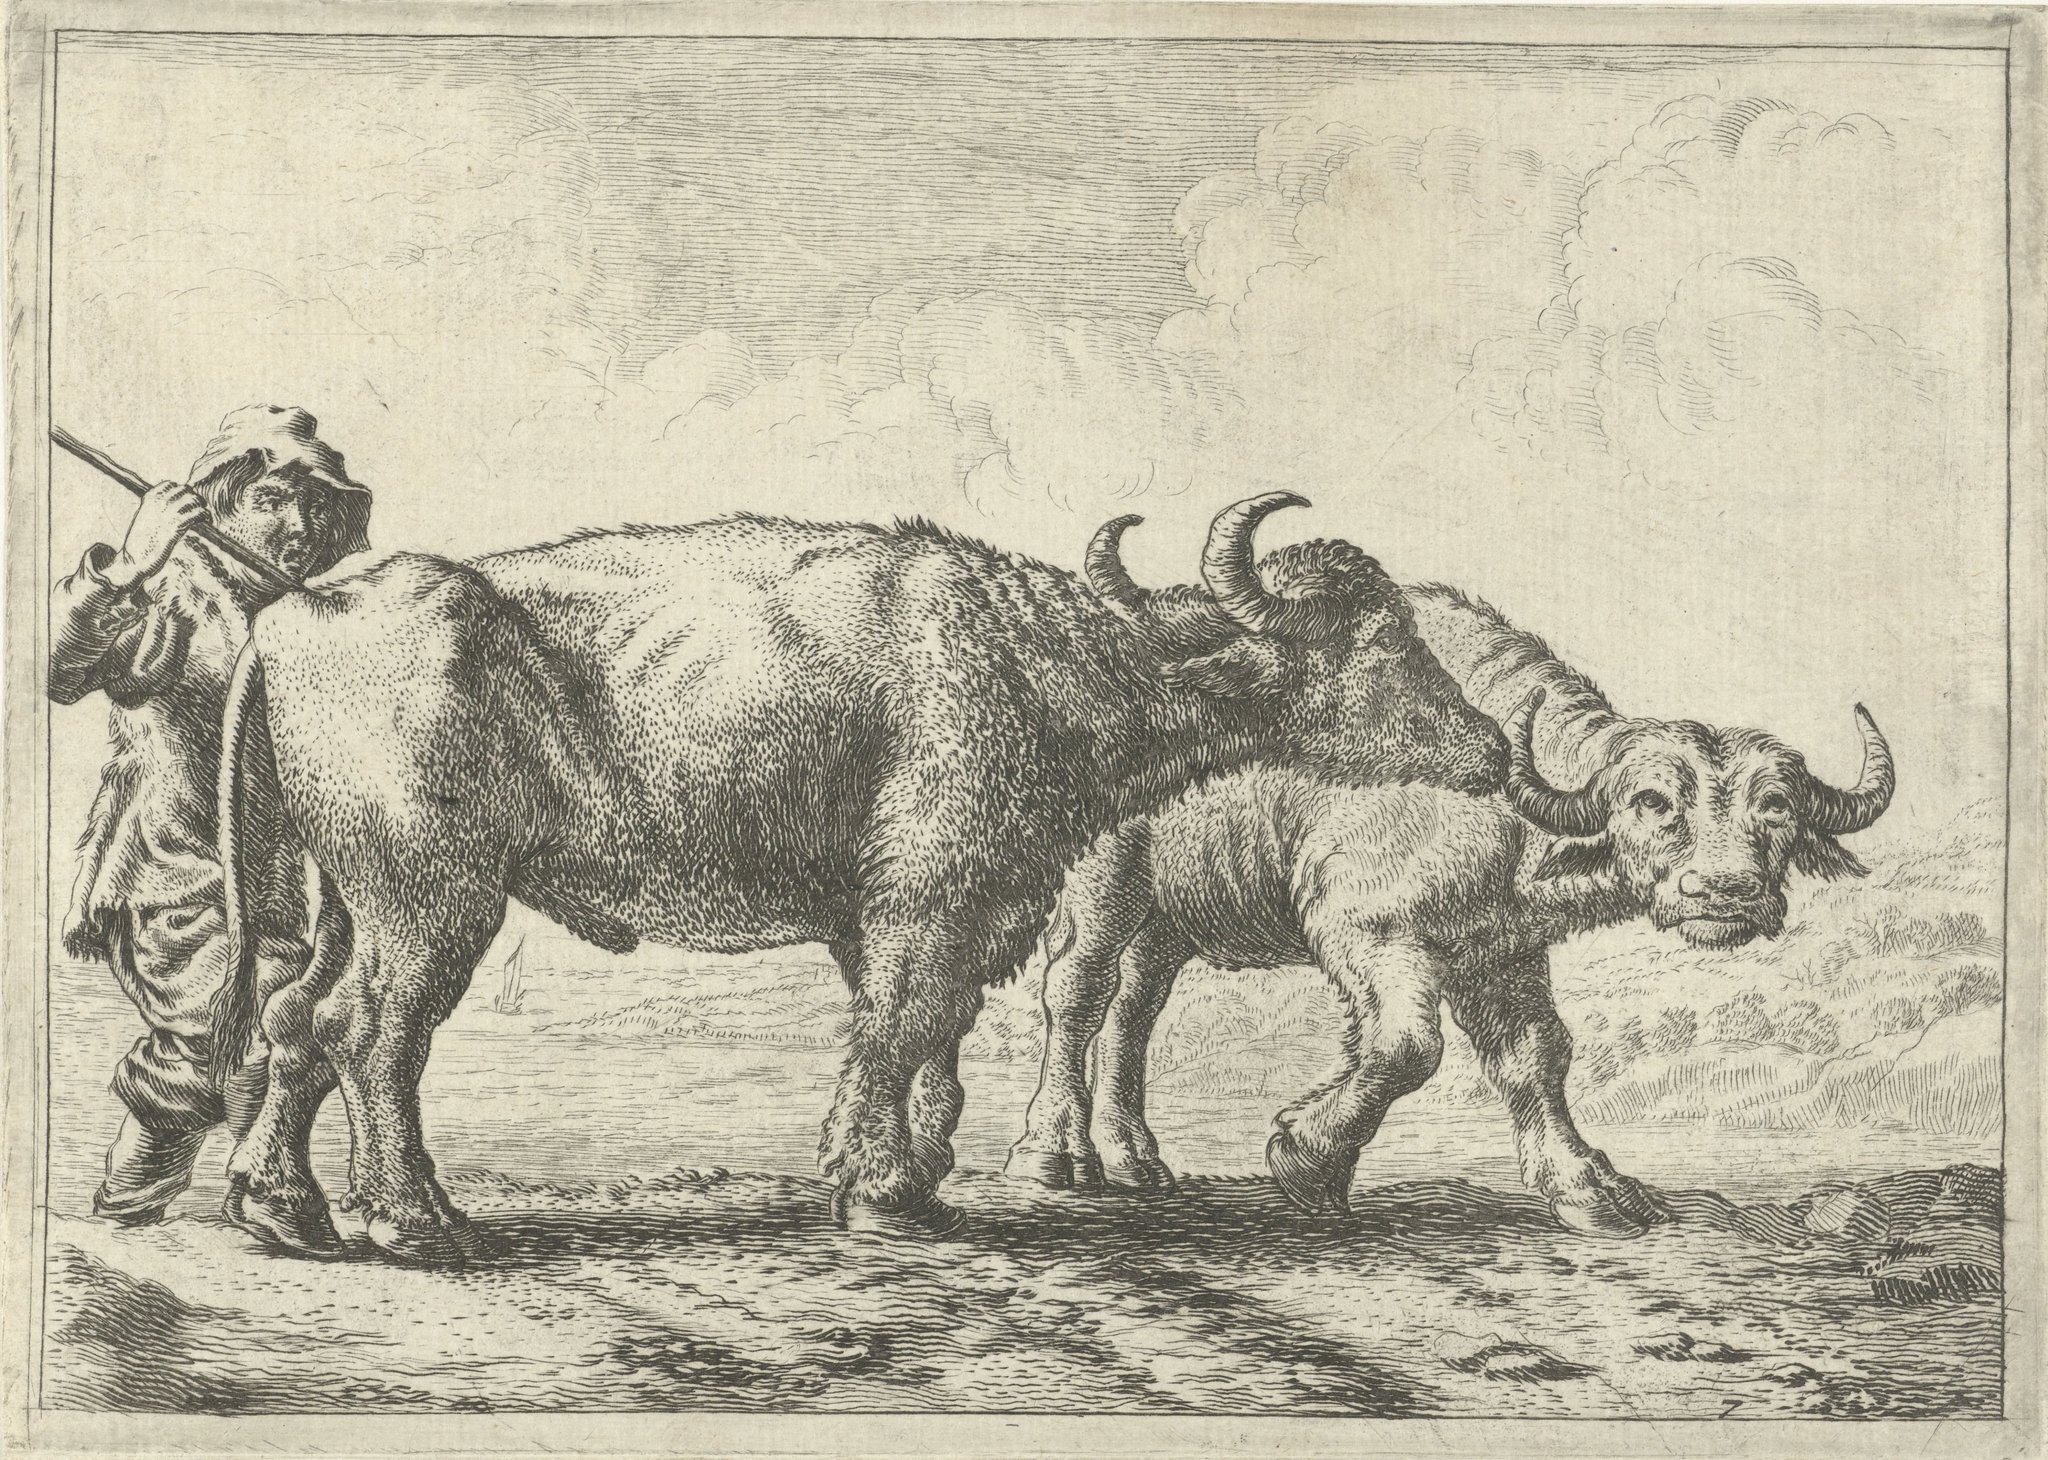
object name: print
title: Verschillende dieren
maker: Anonymous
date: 1636-1692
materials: paper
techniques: etching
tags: hoofed animals: buffalo, herding, herdsman, herdswoman, shepherd, shepherdess, cowherd, etc.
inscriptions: collector's mark: Lugt 2228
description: Kopie naar gelijknamige prent uit een achtdelige serie met voorstellingen van verschillende dieren door Pieter Bodding van Laer.